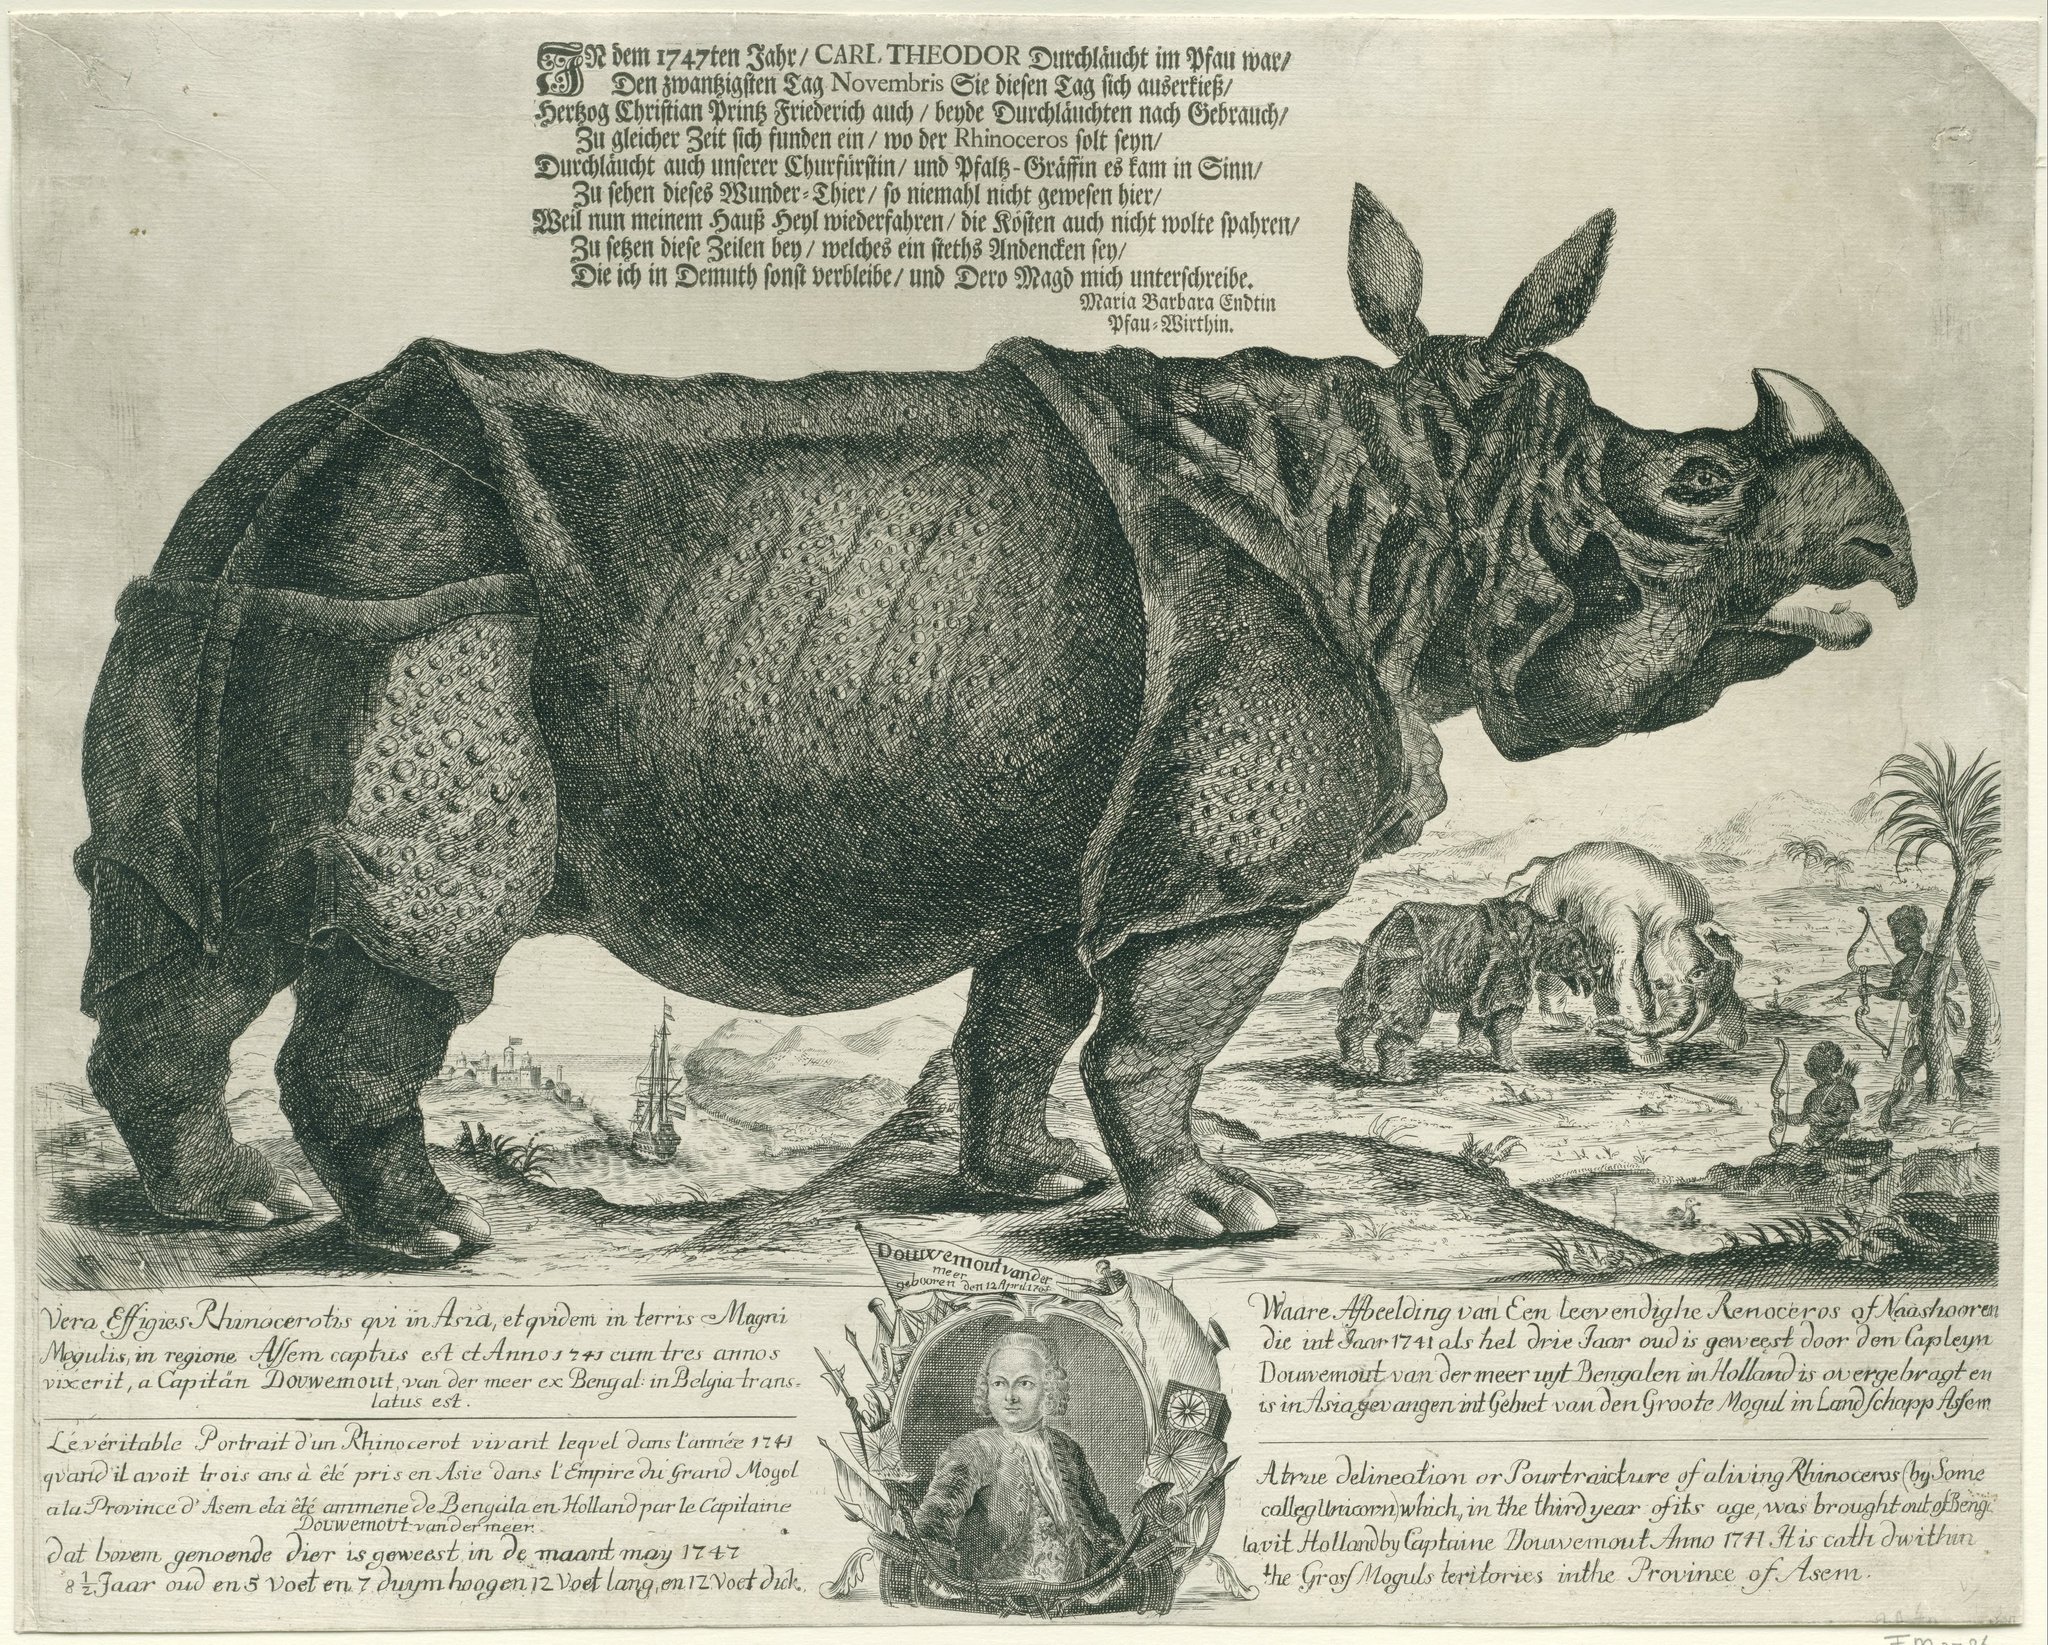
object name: print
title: Clara in Mannheim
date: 1747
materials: paper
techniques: engraving, etching, letterpress printing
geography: northern netherlands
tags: london, hoofed animals: rhinoceros, animals (+ fighting animals; aggressive relations), trunked animals: elephant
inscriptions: collector's mark: Lugt 2228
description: Clara’s success prompts Mout to make a new print in 1747. It now includes his own portrait and the ship on which Clara had sailed to Europe. The owner of the inn in Mannheim where Clara is on view, Maria Barbara Endtin, has a poem printed to accompany it after Charles Theodor, Elector Palatine, visited Clara. Good advertizing!